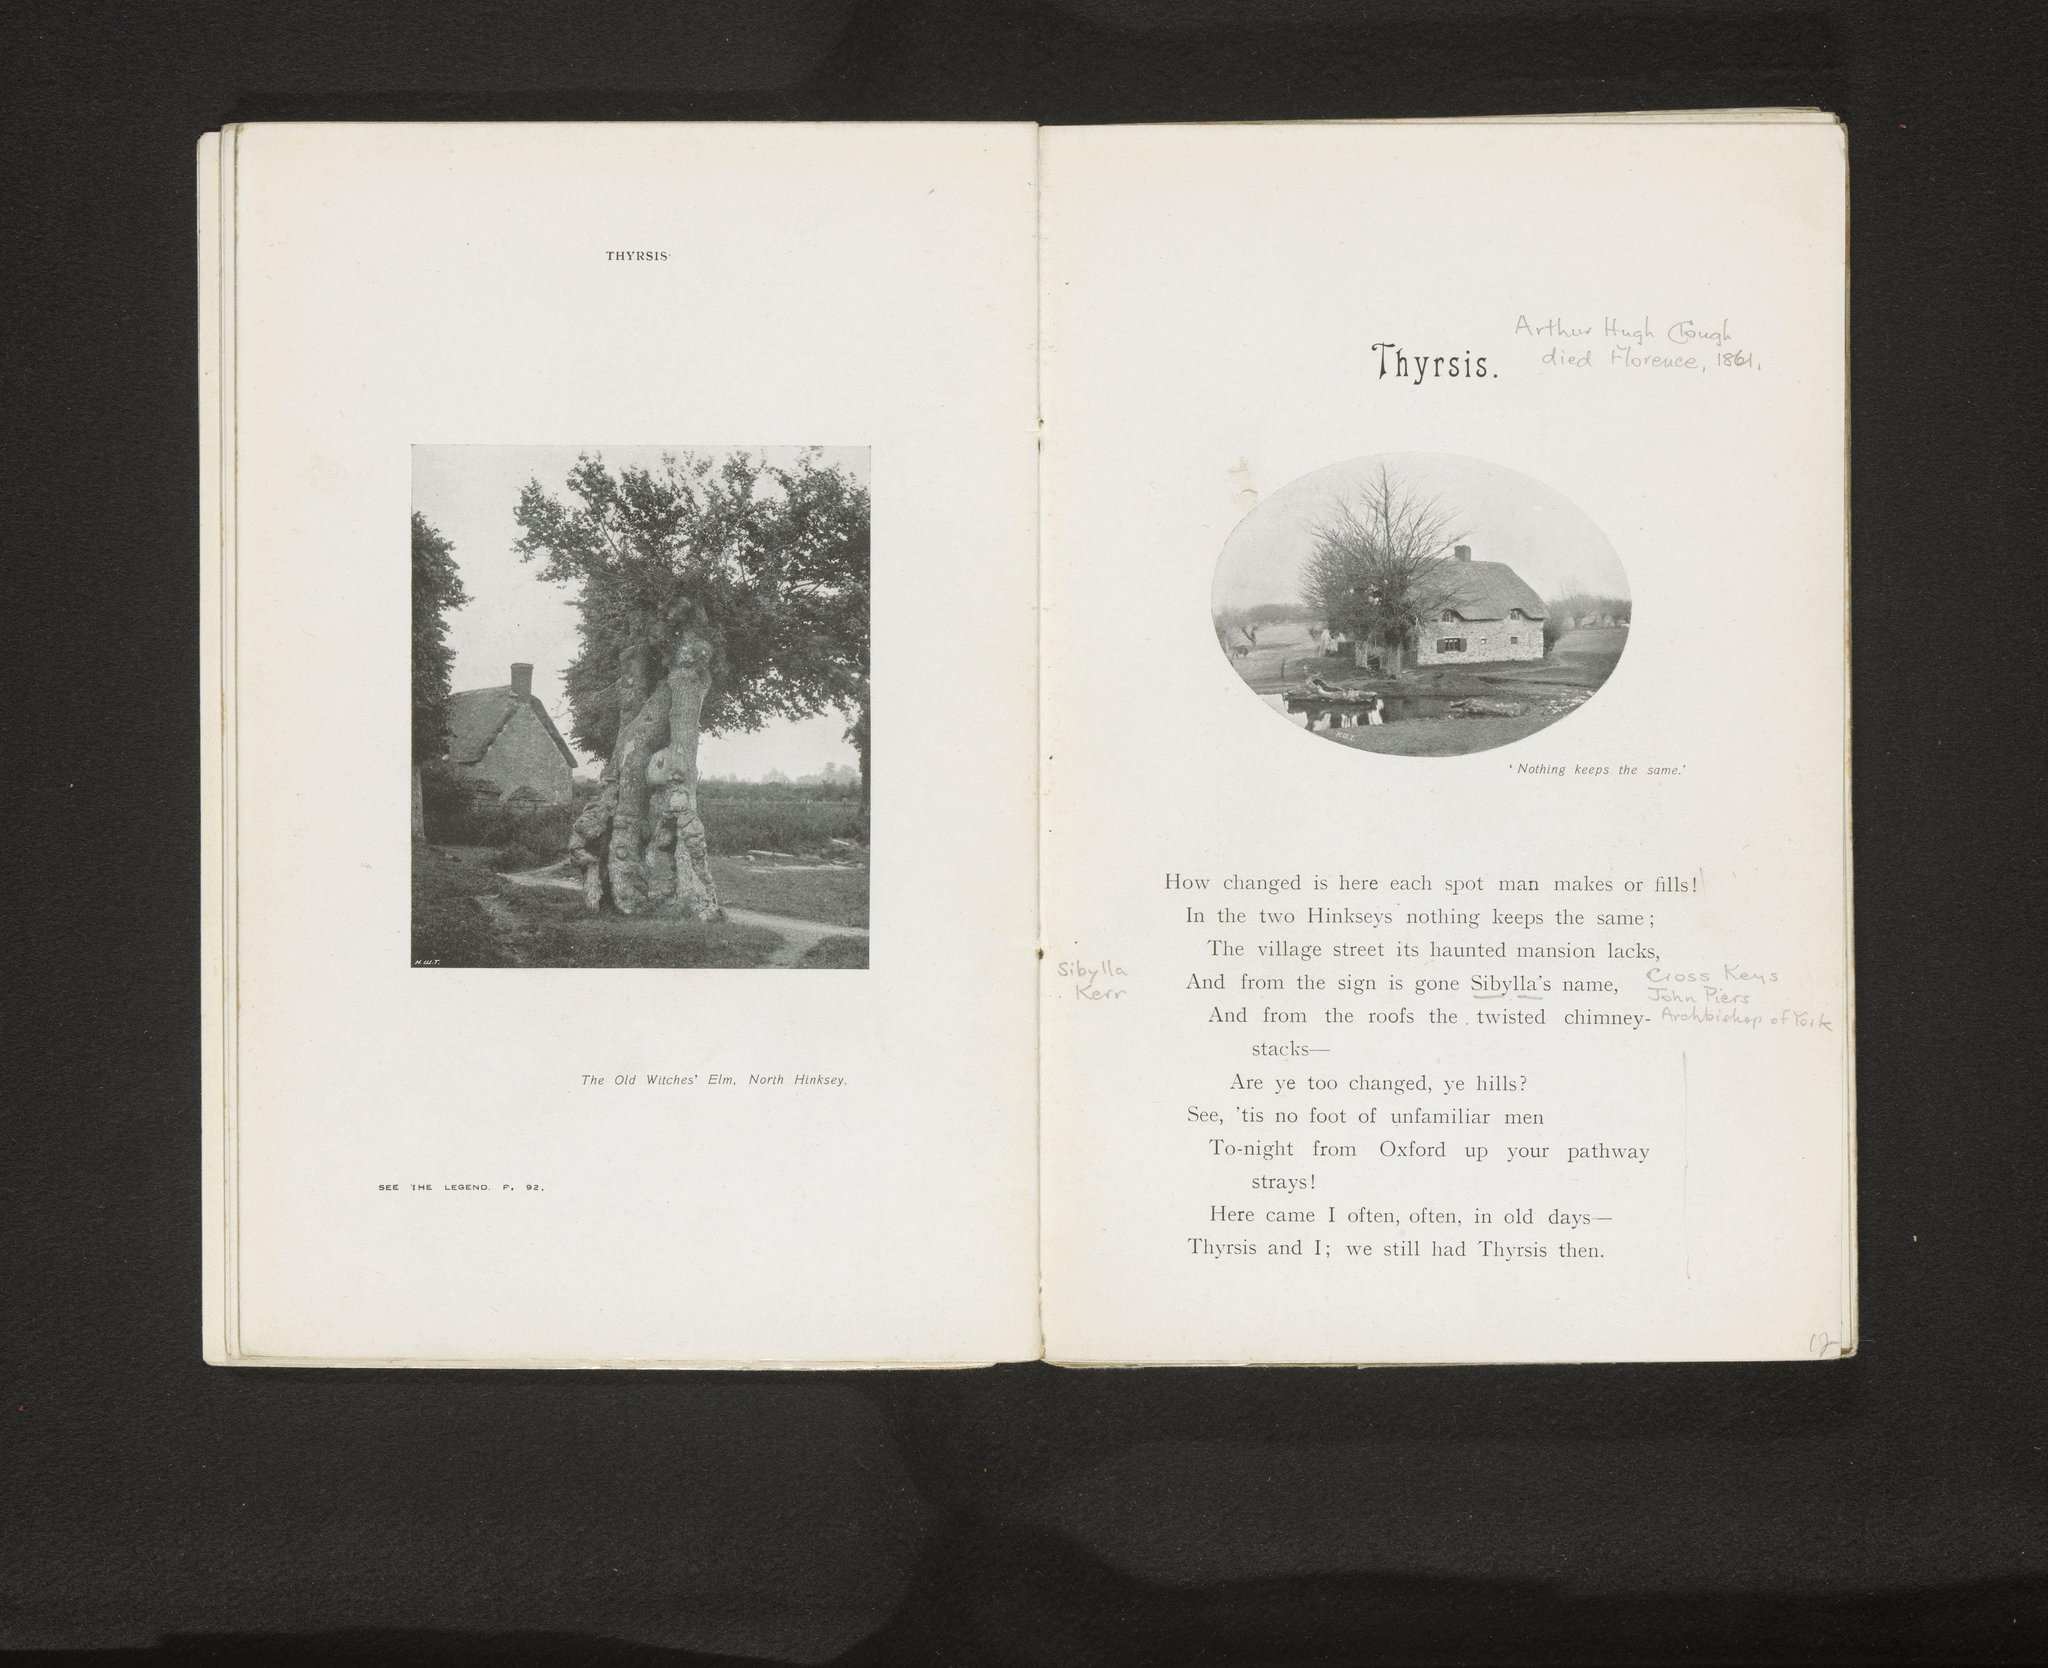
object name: page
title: Iep te North Hinksey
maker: henry w. taunt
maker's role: fotograaf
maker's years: 1842-1922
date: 1907-1912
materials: paper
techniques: autotype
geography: north hinksey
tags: trees: elm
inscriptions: inscription: ‘The Old Witches' Elm, North Hinksey’